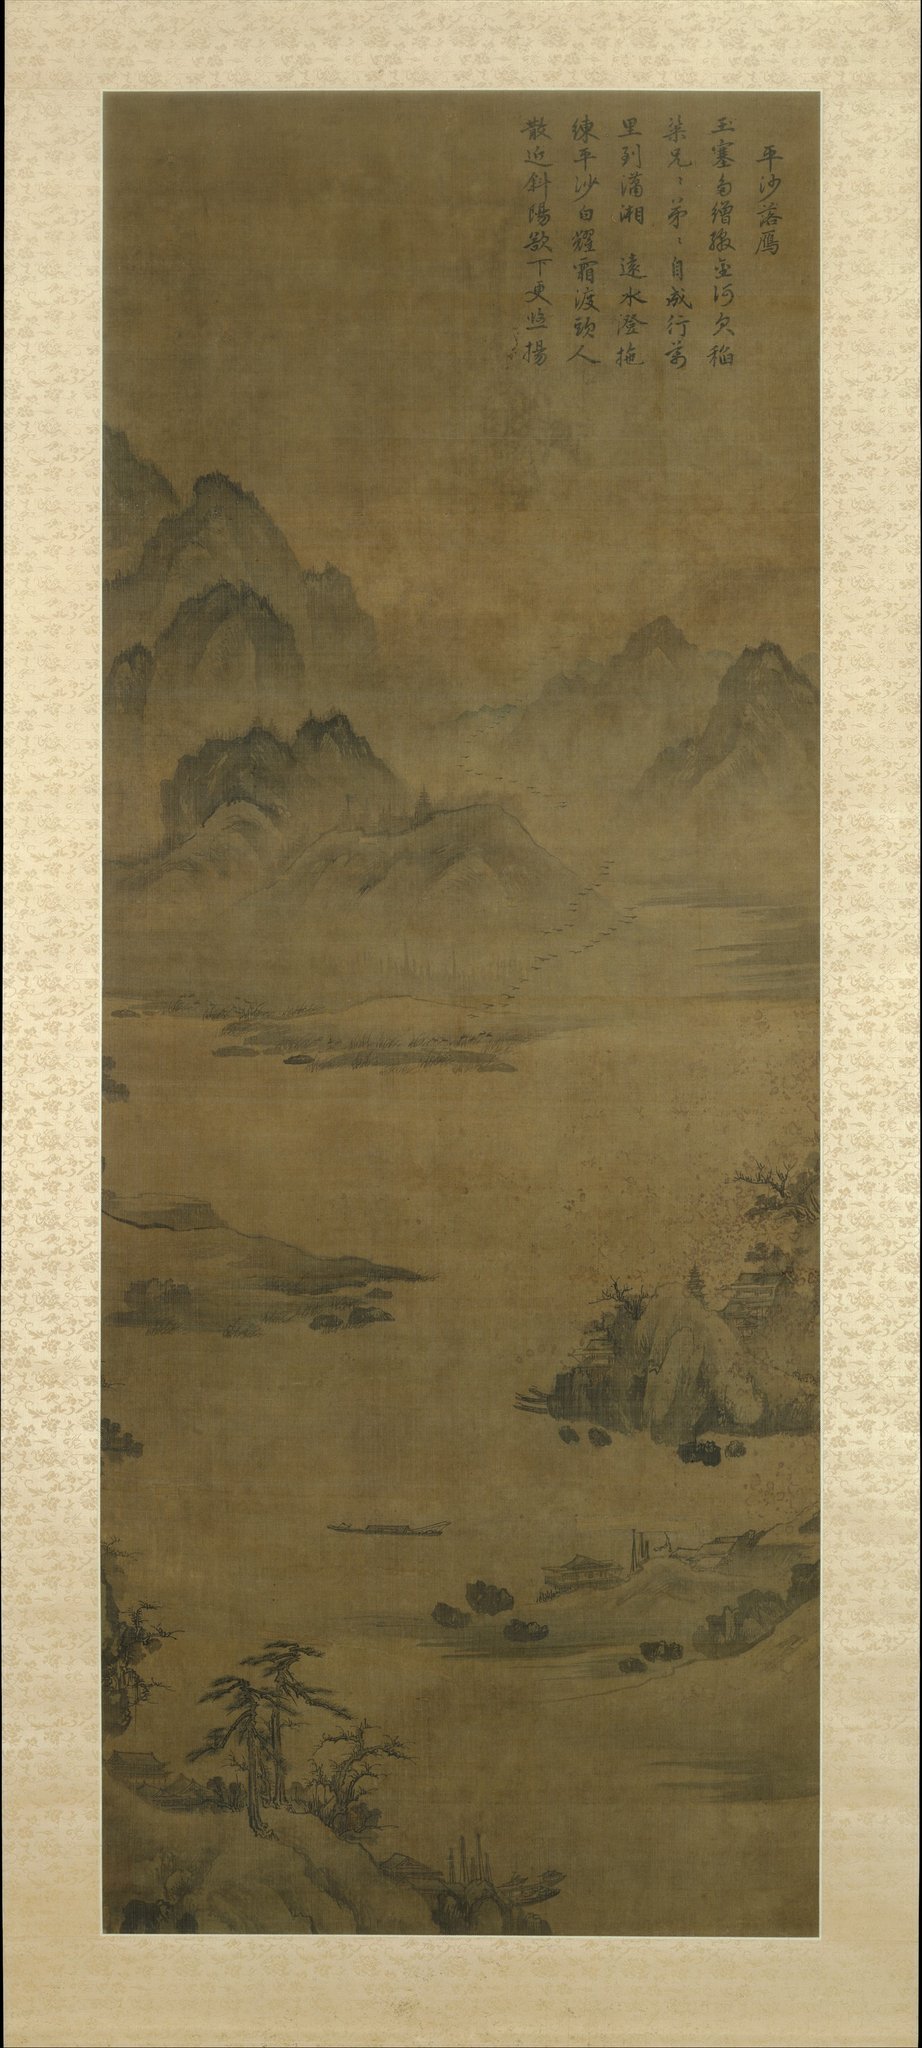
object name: hanging scroll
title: Wild geese descending to sandbar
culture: korean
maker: unidentified artist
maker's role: artist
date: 1467-1533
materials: ink, silk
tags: rivers,mountains,landscapes